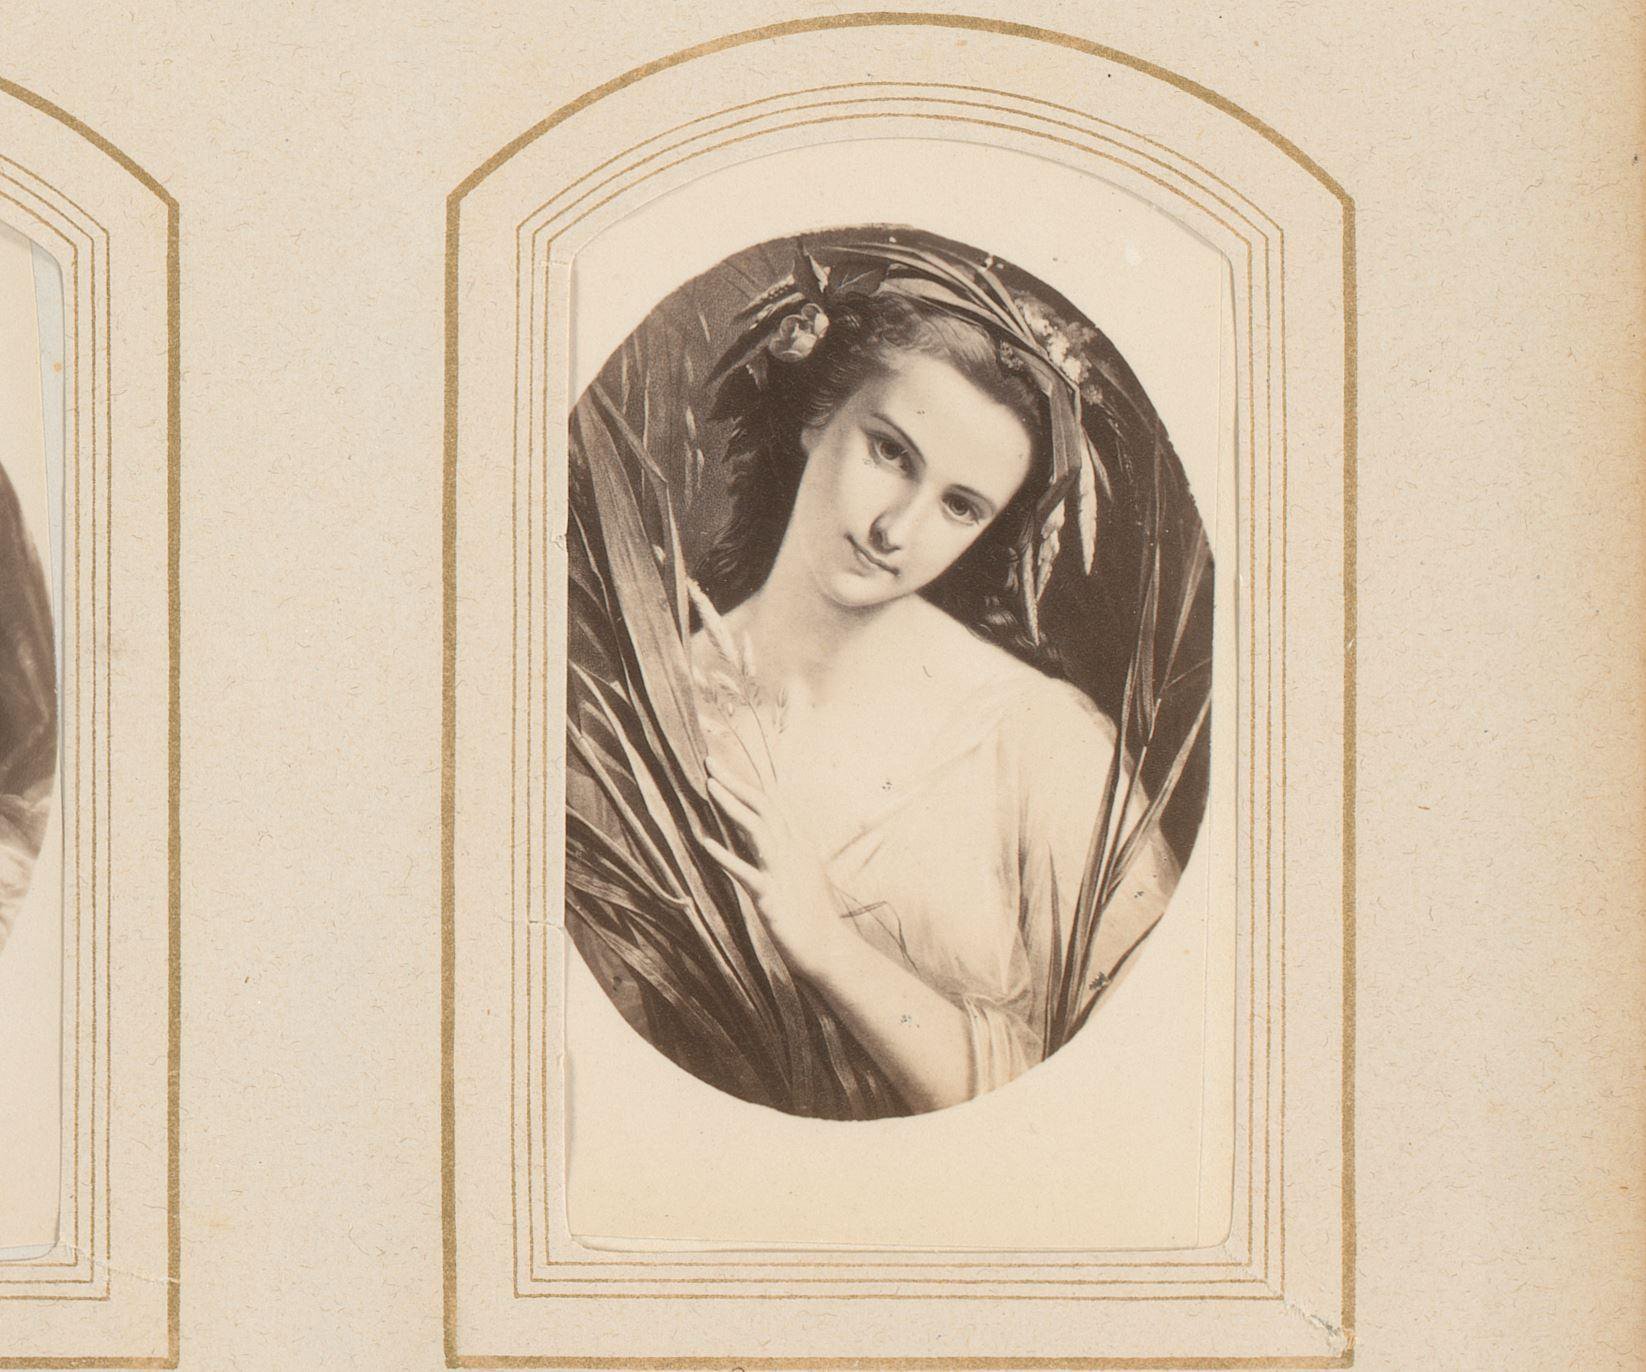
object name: album leaf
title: Fotoreproductie van Nymphe des pres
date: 1870-1890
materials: cardboard, photographic support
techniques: albumen print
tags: nymphs (in general); 'ninfe in commune' (ripa), painting, drawing and the graphic arts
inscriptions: inscription: ‘Brochart,/ 29. Nymphe des prés.’, annotation: ‘[...]’